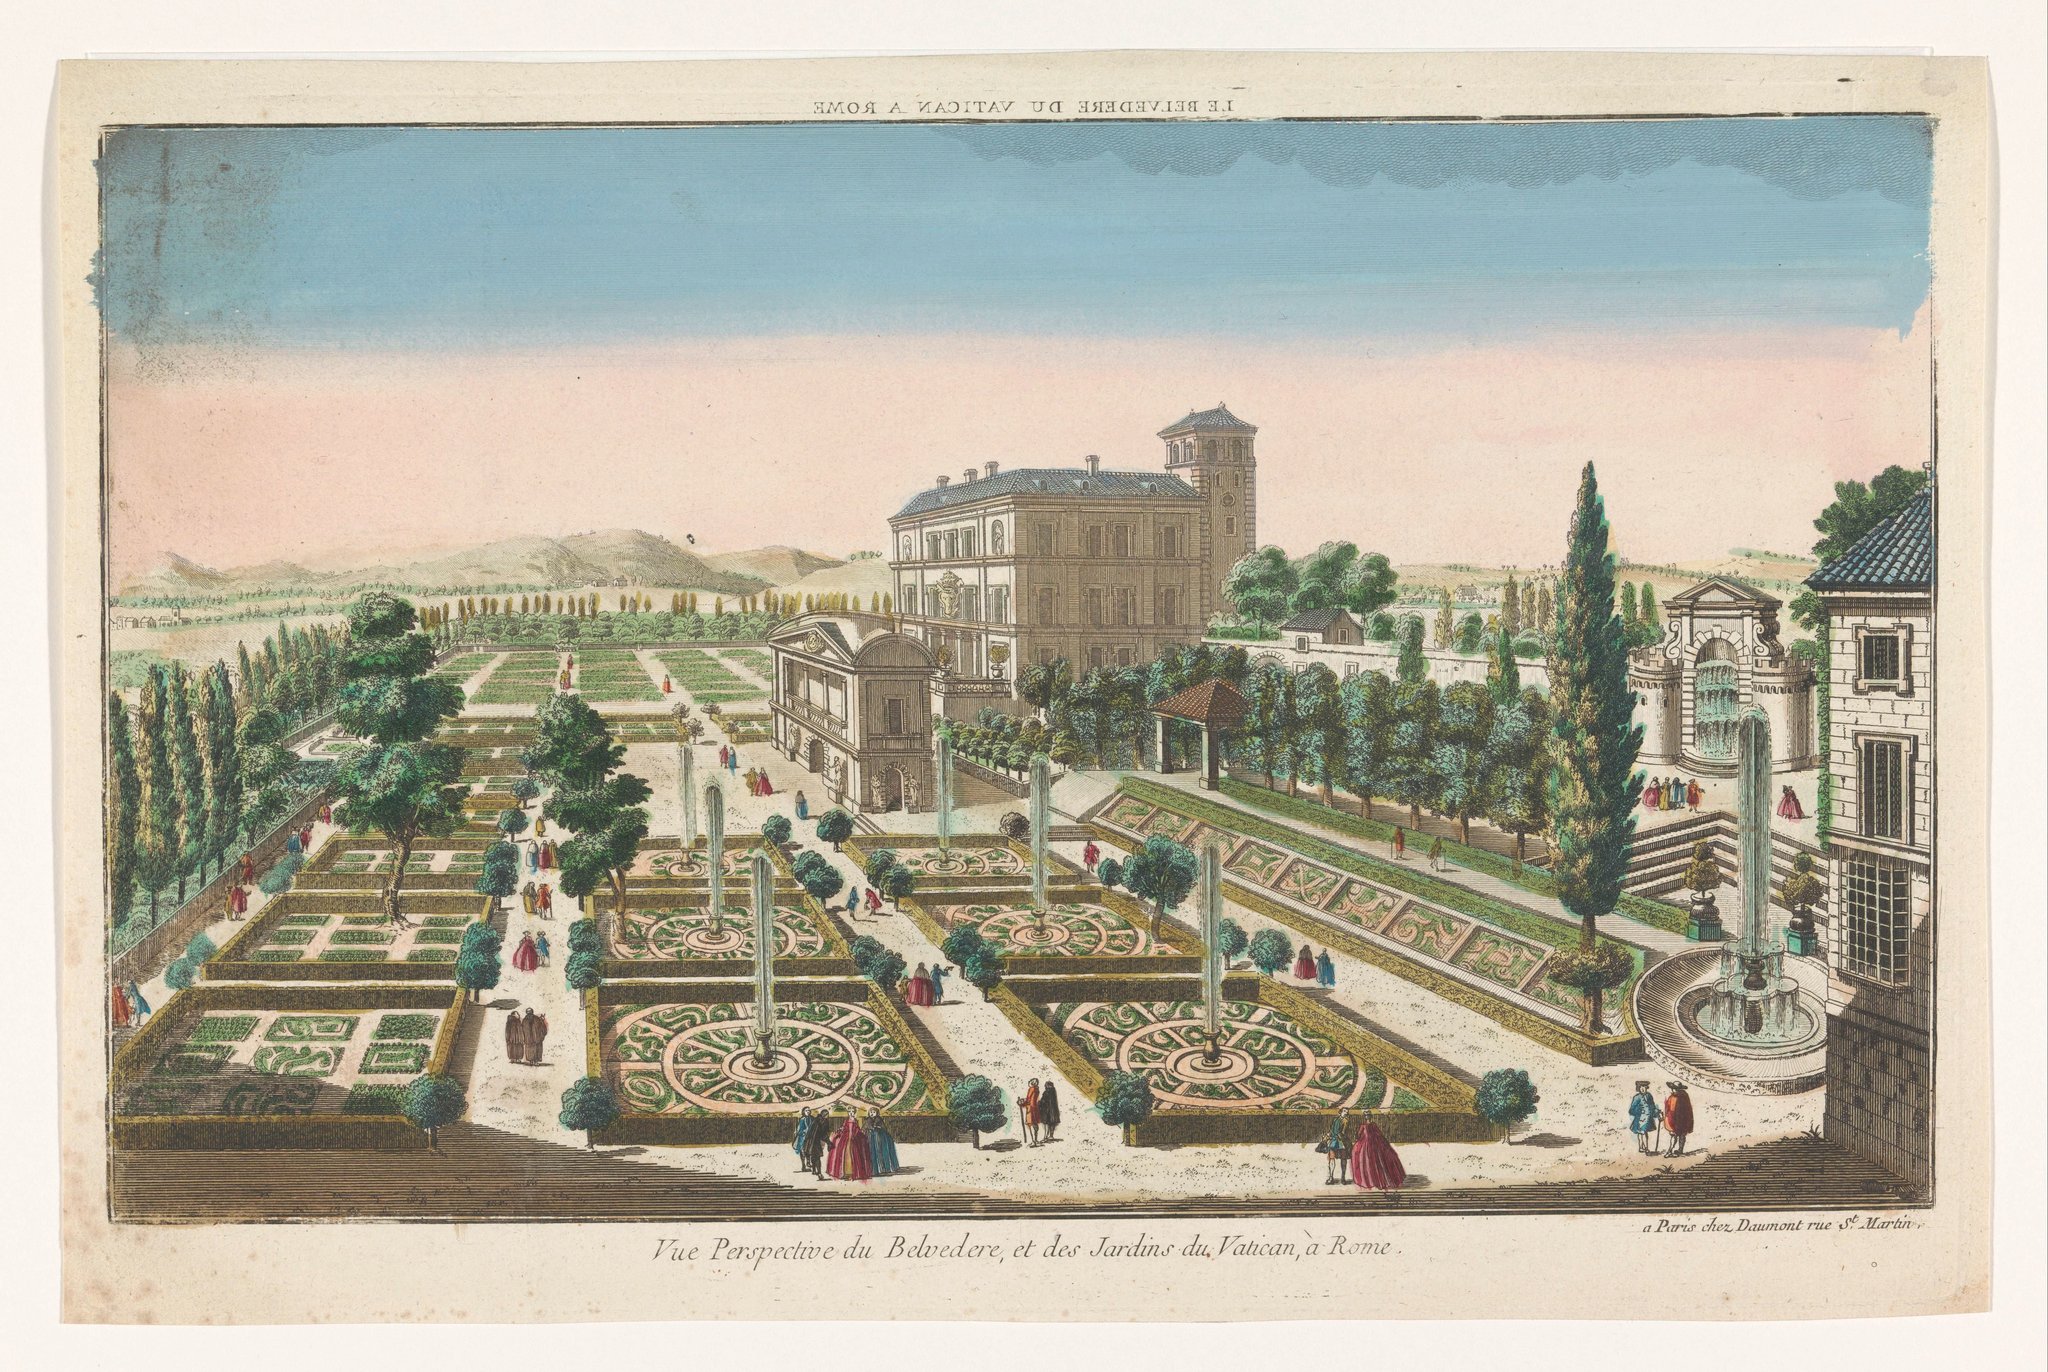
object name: print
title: Gezicht op de Giardini Vaticani te Vaticaanstad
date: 1745-1775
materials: paper, watercolor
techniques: brush, etching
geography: france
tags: garden, garden fountain, ornamental plants, civic architecture; edifices; dwellings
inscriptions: collector's mark: Lugt 2233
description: Rechts de Fontana degli Specchi. In het midden het Casino di Pio IV. Op de voorgrond de Giardino de Semplici. Op de achtergrond rechts de Fontana delle Torri.